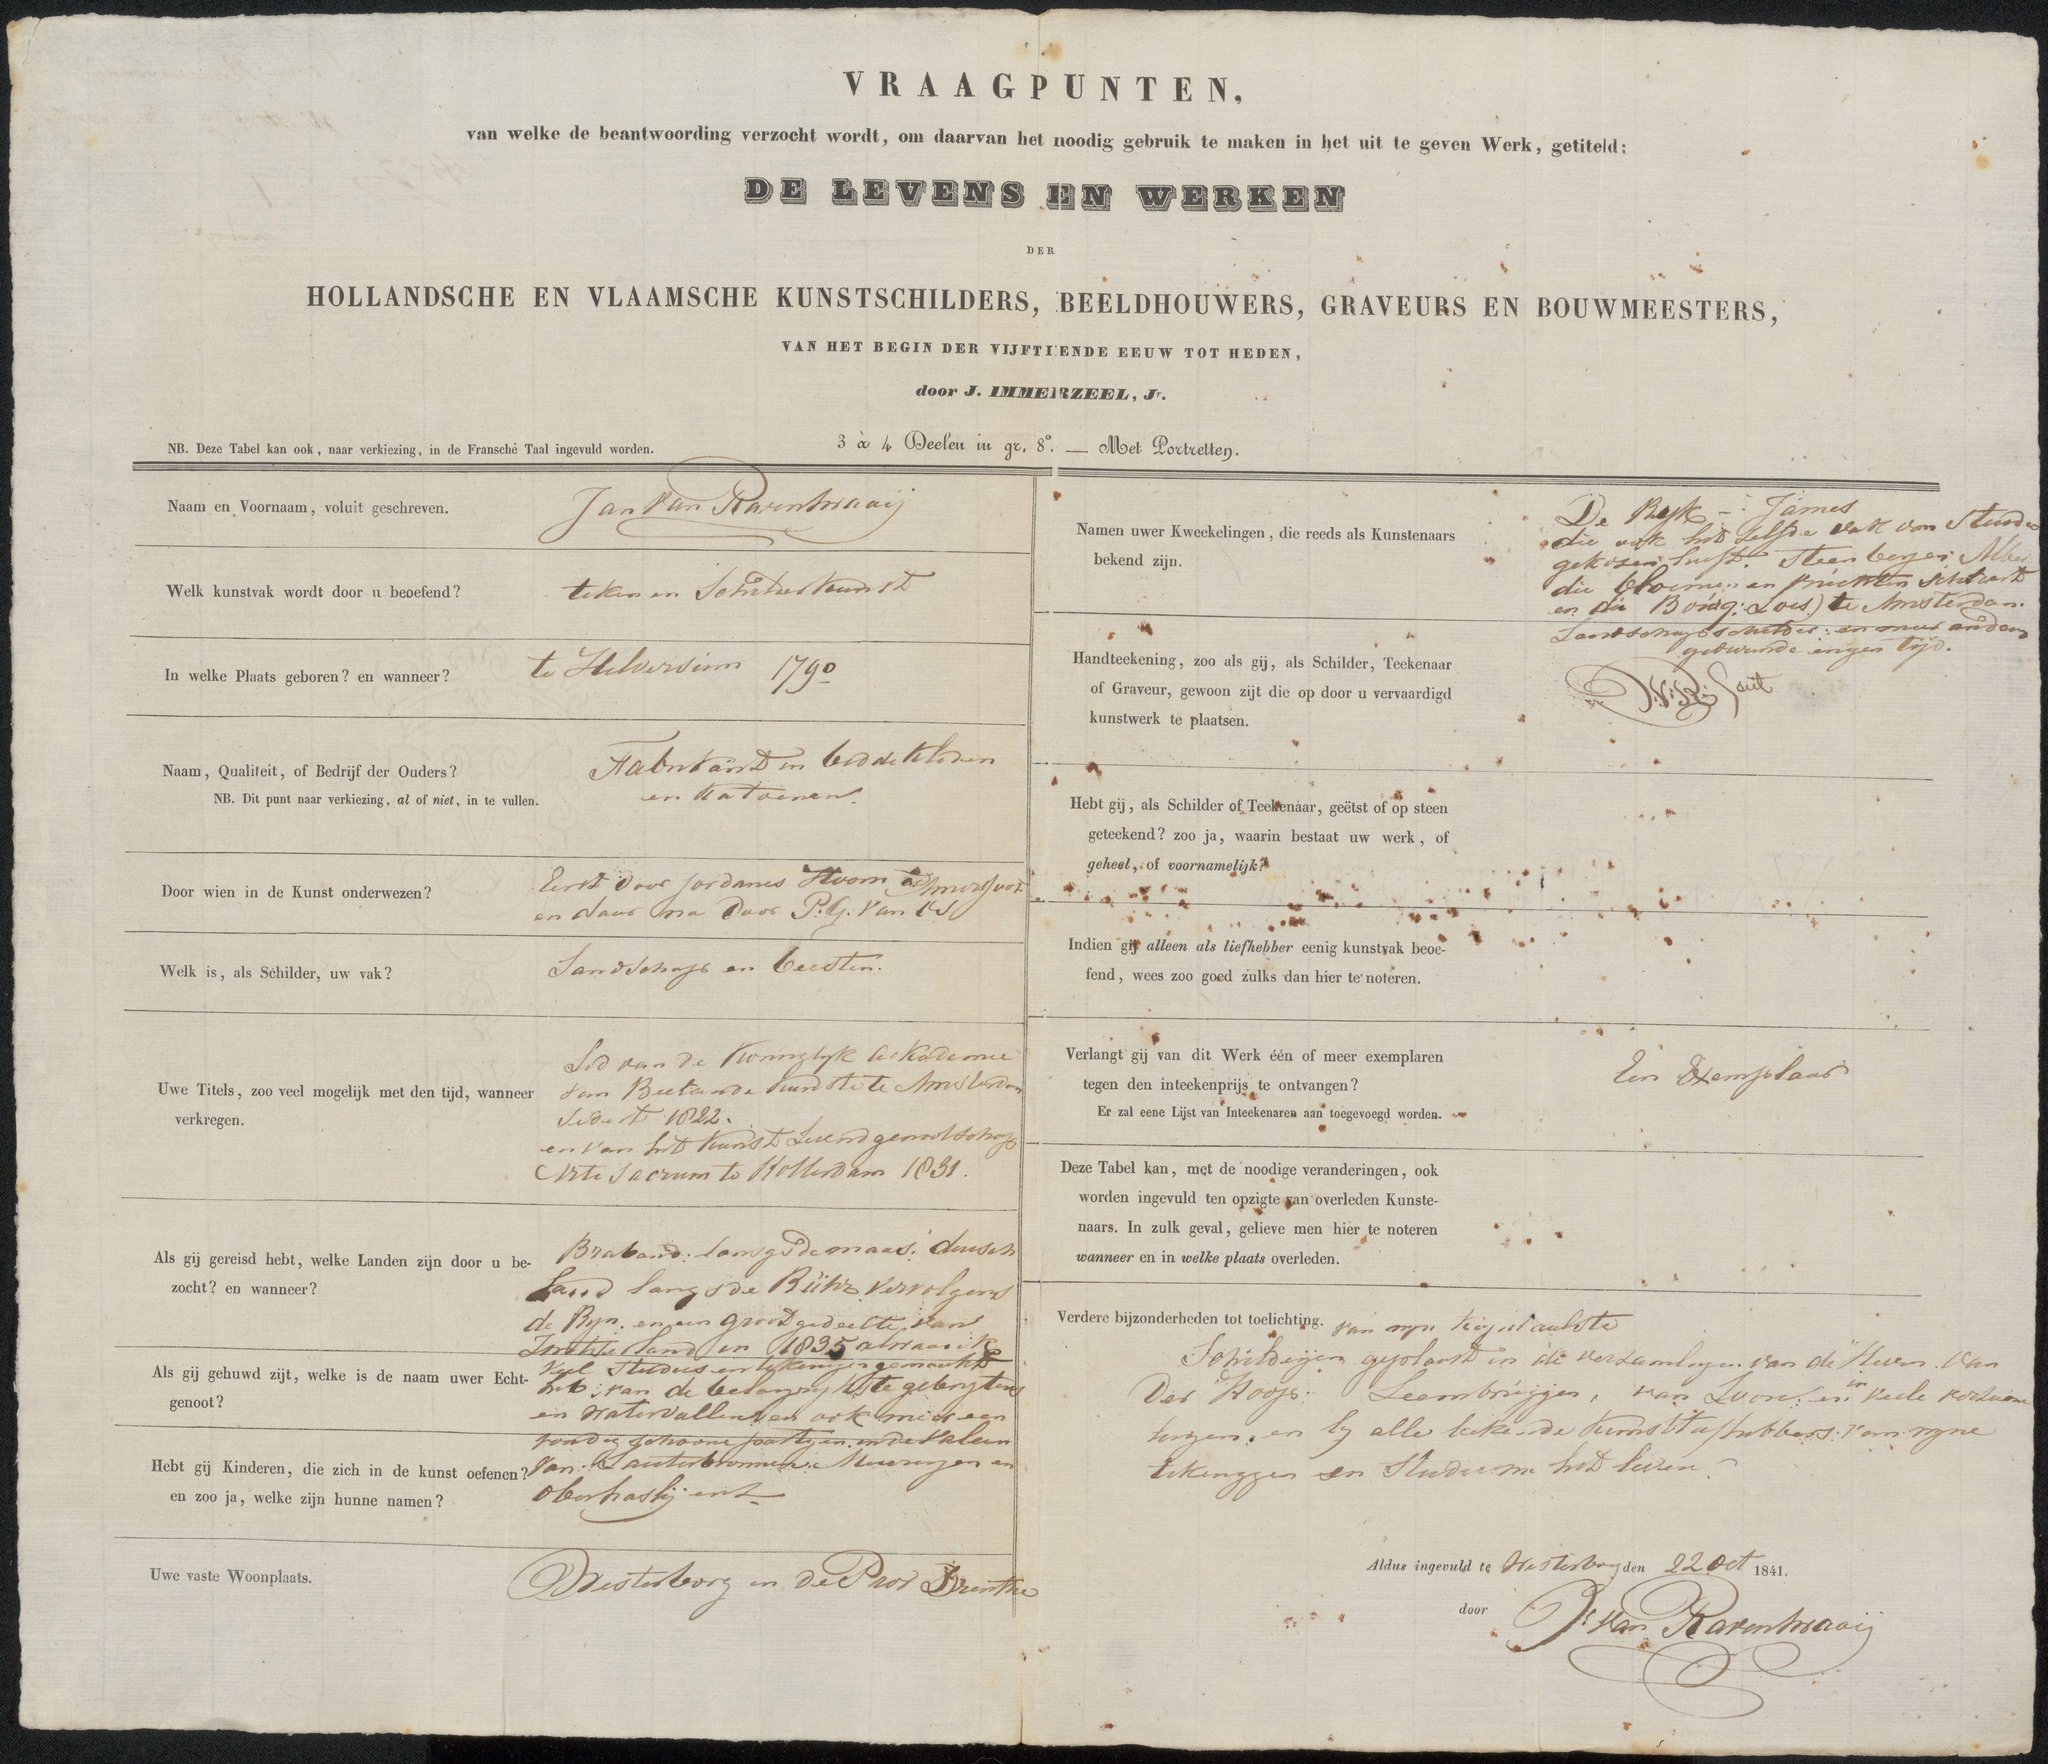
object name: questionnaire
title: Enquêteformulier ingevuld door Jan van Ravenswaay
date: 1841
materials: ink, paper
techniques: pen, printing, writing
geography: westerbork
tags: painter, print maker, draughtsman, jan van ravenswaay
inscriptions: inscription: ‘Vraagpunten,/ van welke de beantwoording verzocht wordt, om daarvan het noodig gebruik te maken in het uit te geven Werk, getiteld: De levens en werken/ der Hollandsche en Vlaamsche kunstschilders, beeldhouwers,/ graveurs en bouwmeesters, van het begin der vijftiende eeuw tot heden/ door J. Immerzeel, Jr.’, watermark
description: Opgenomen in: Immerzeel, J. Jr., De levens en werken der Hollandsche en Vlaamsche kunstschilders, beeldhouwers, graveurs en bouwmeesters, van het begin der vijftiende eeuw tot heden, Amsterdam: J.C. van Kesteren, 1842-1843.